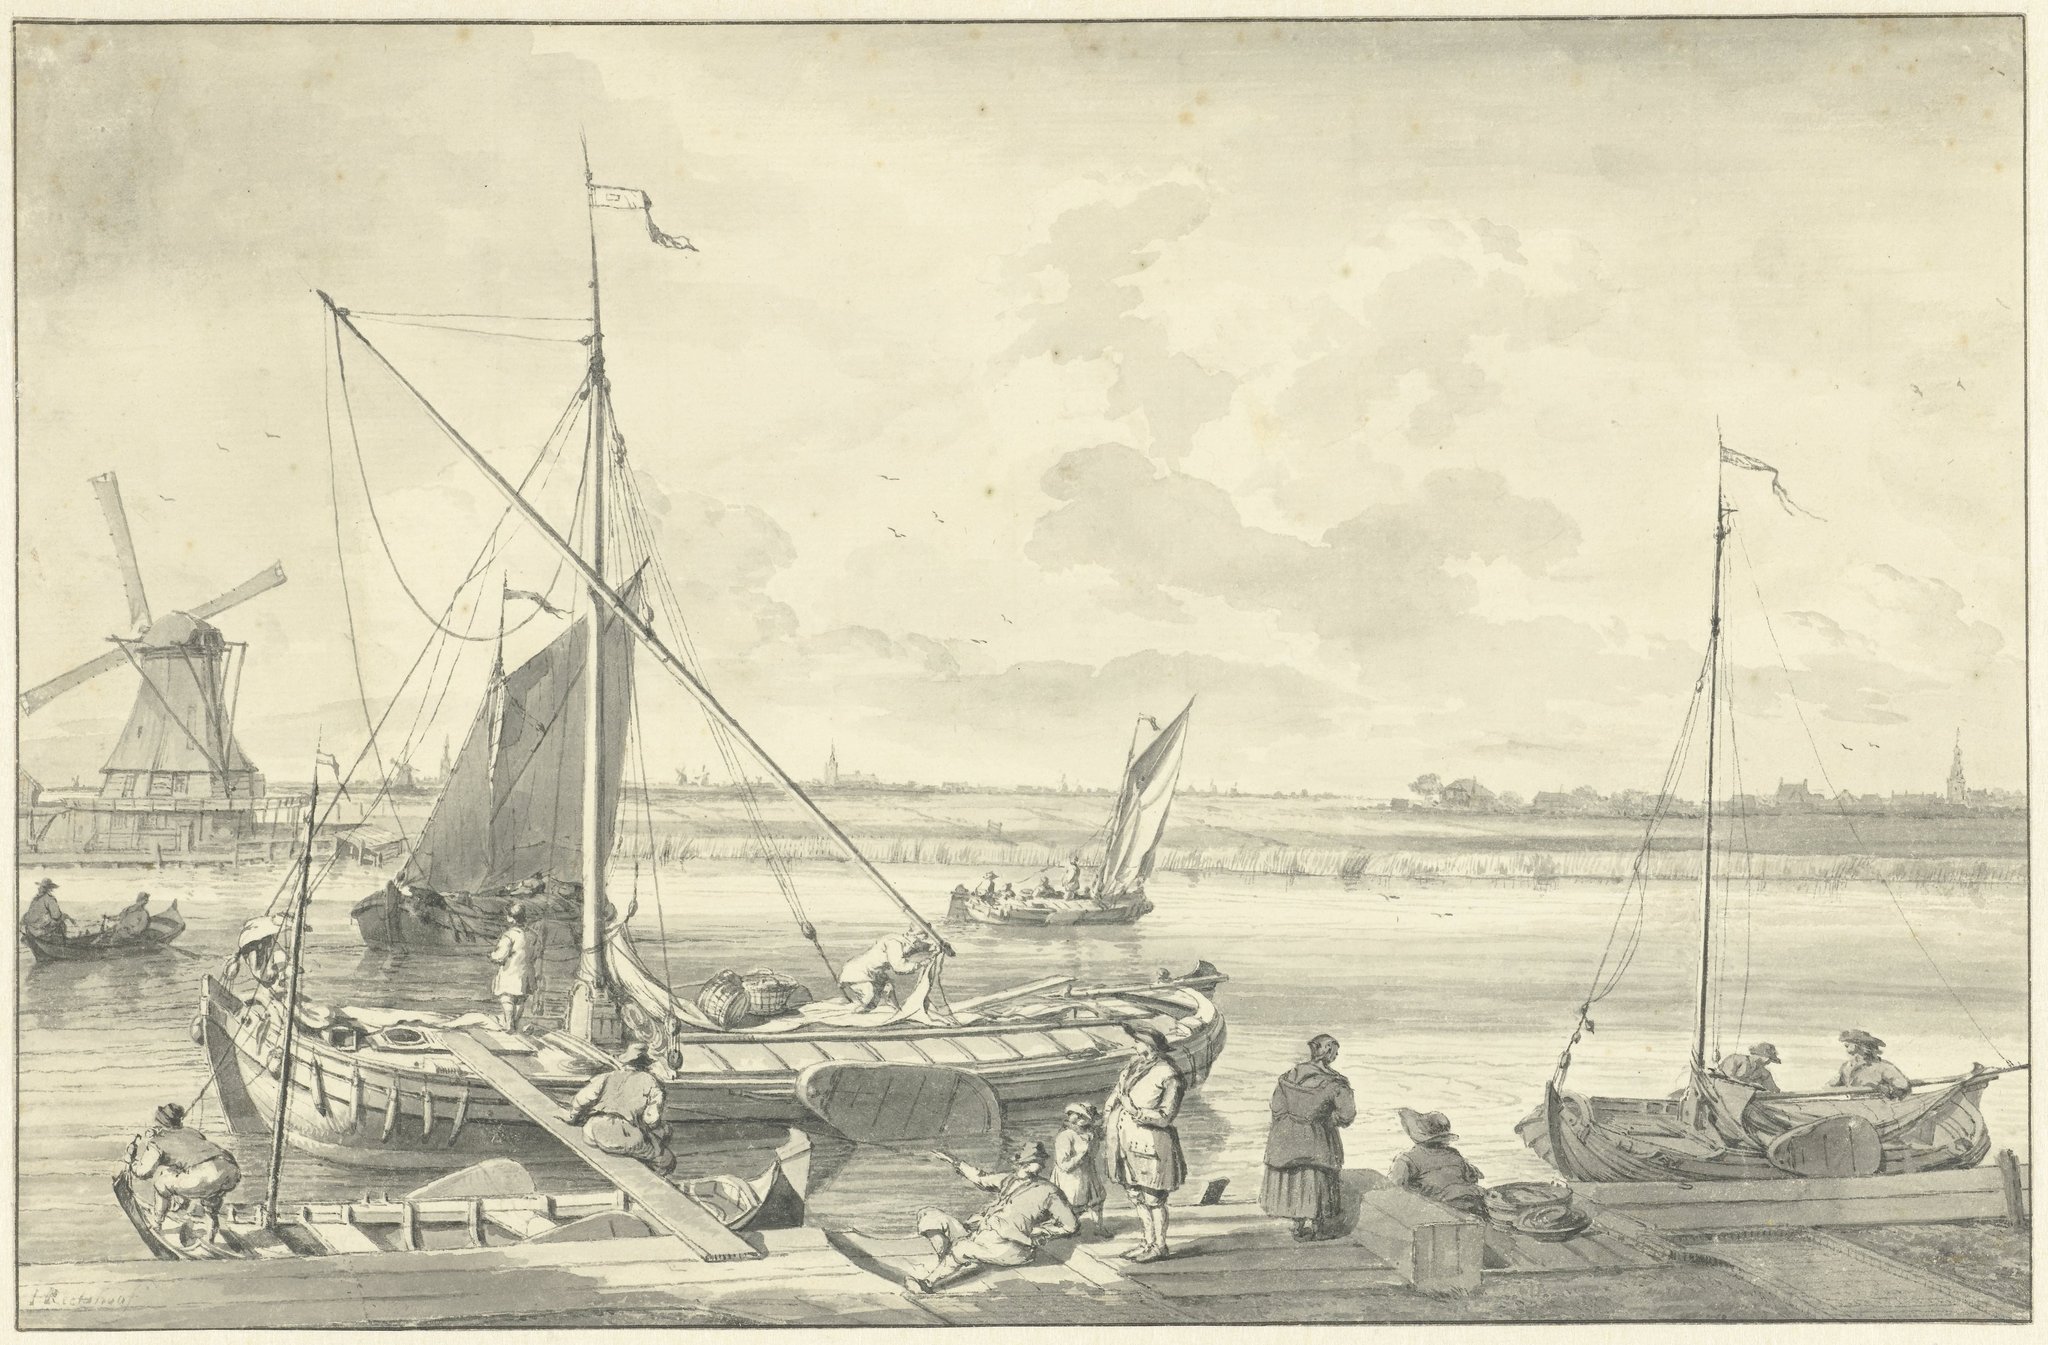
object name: drawing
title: Riviergezicht met schepen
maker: hendrik rietschoof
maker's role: draughtsman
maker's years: 1678-1746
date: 1697-1746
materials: ink, paper, pencil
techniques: brush, pen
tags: ships (in general) - cc - more than one ship